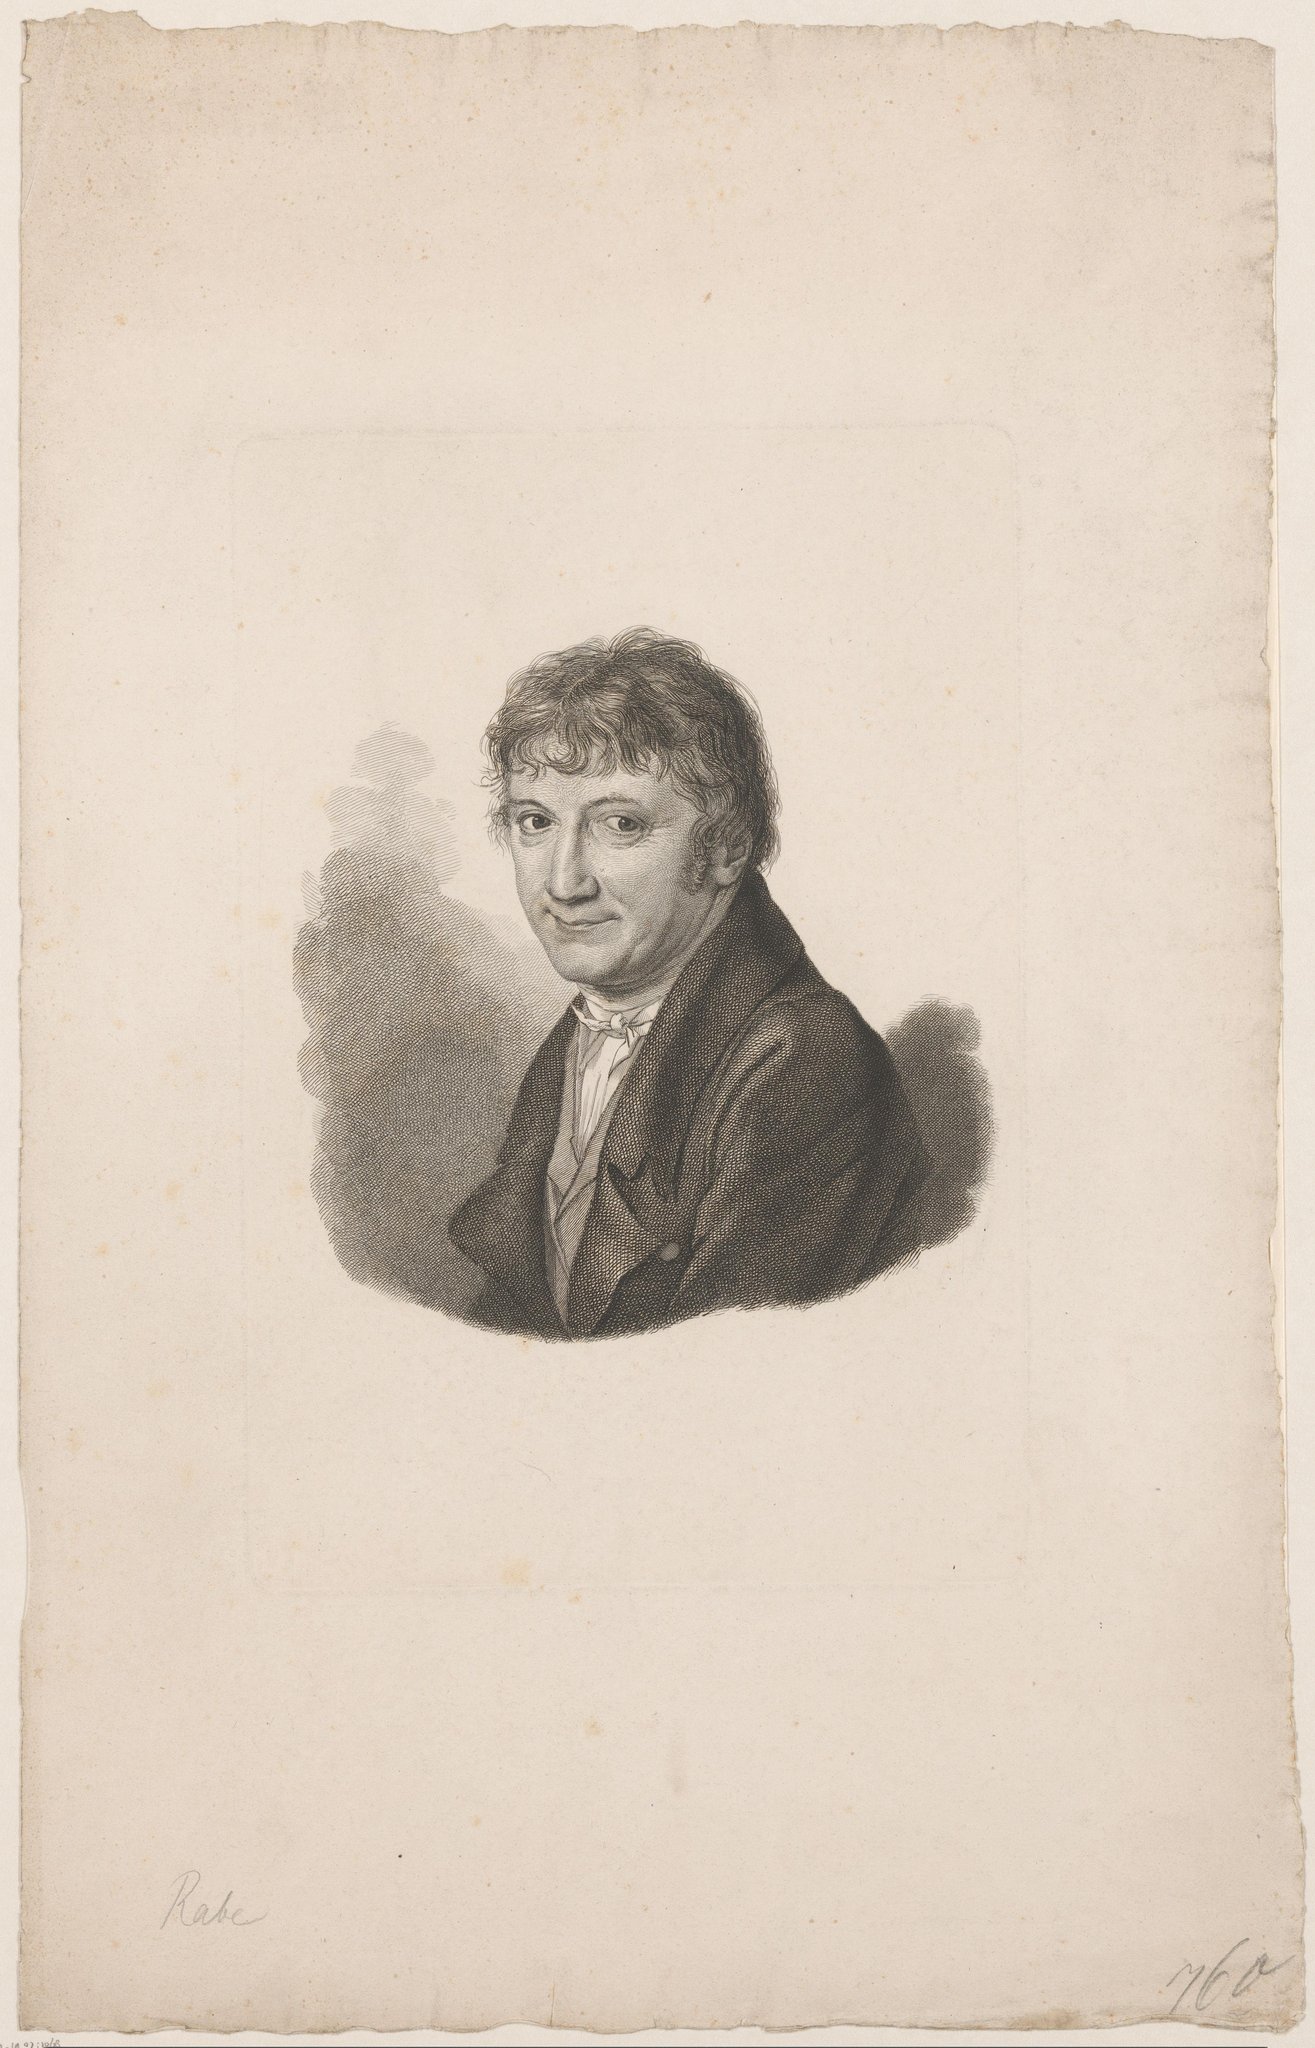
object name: print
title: Portret van Rabe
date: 1800-1899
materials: paper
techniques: etching, engraving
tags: historical persons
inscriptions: collector's mark: Lugt 2228